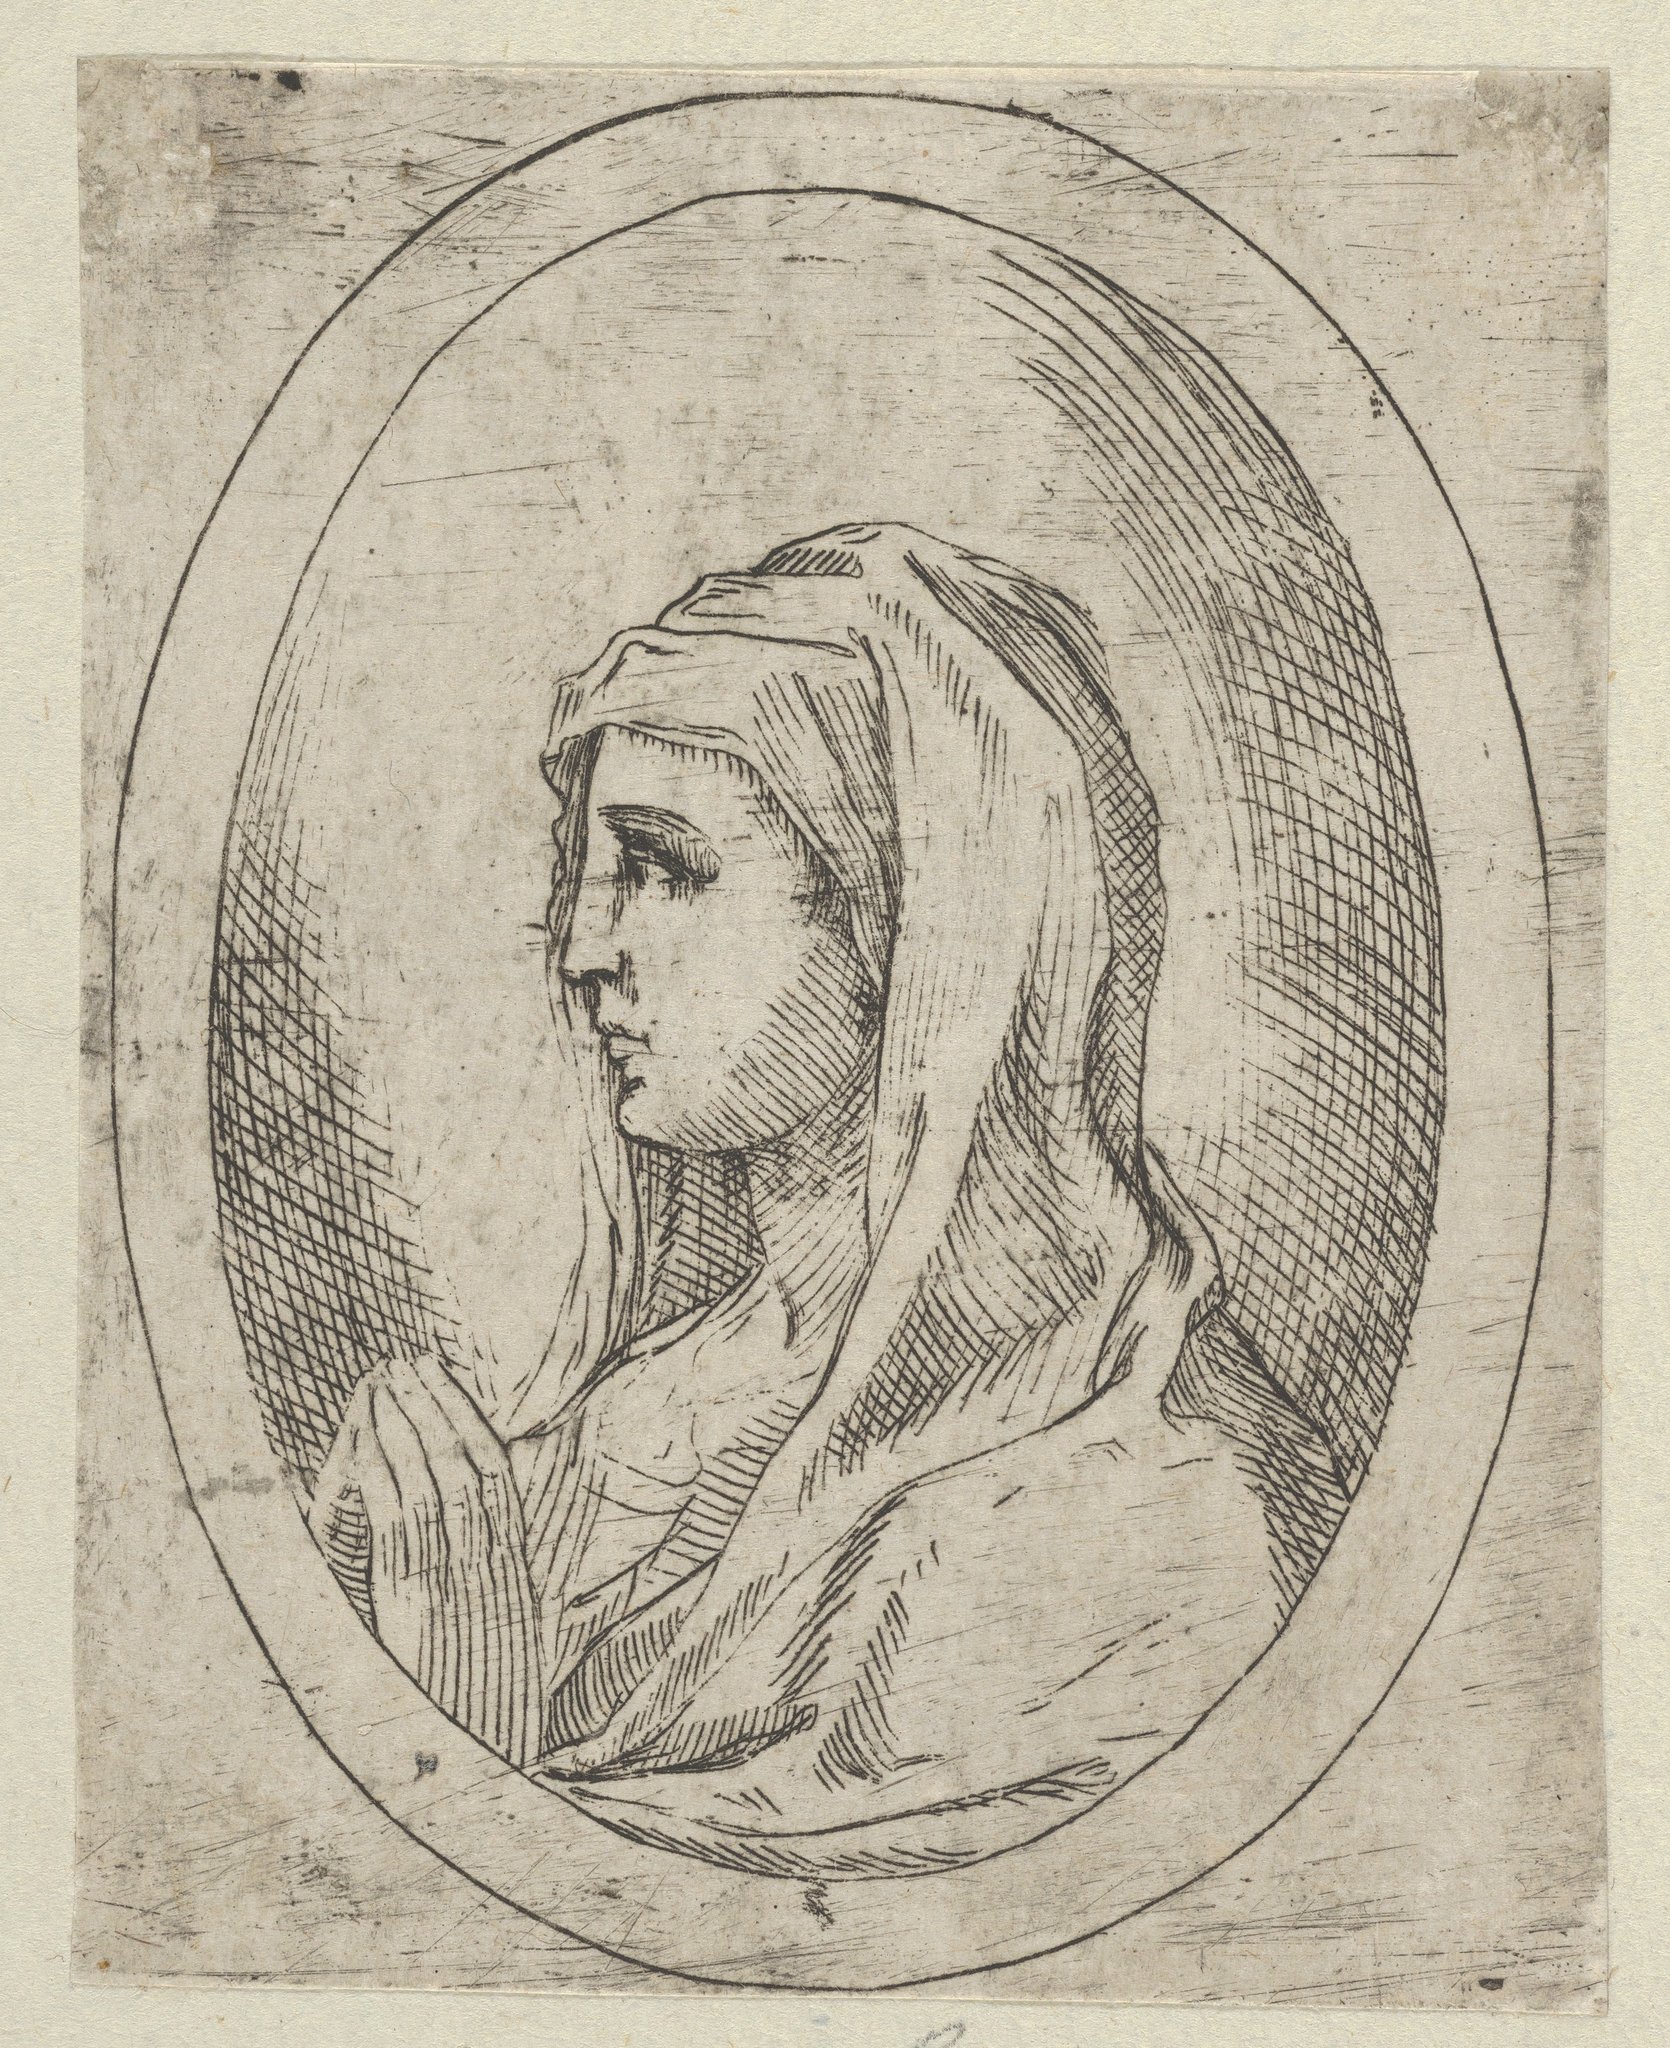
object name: print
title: The Virgin in prayer, seen in profile facing left, in an oval frame, from "Christ, the Virgin, and Thirteen Apostles"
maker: anonymous, 17th century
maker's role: artist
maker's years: 1600-1700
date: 1600-1640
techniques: etching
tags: profiles,virgin mary